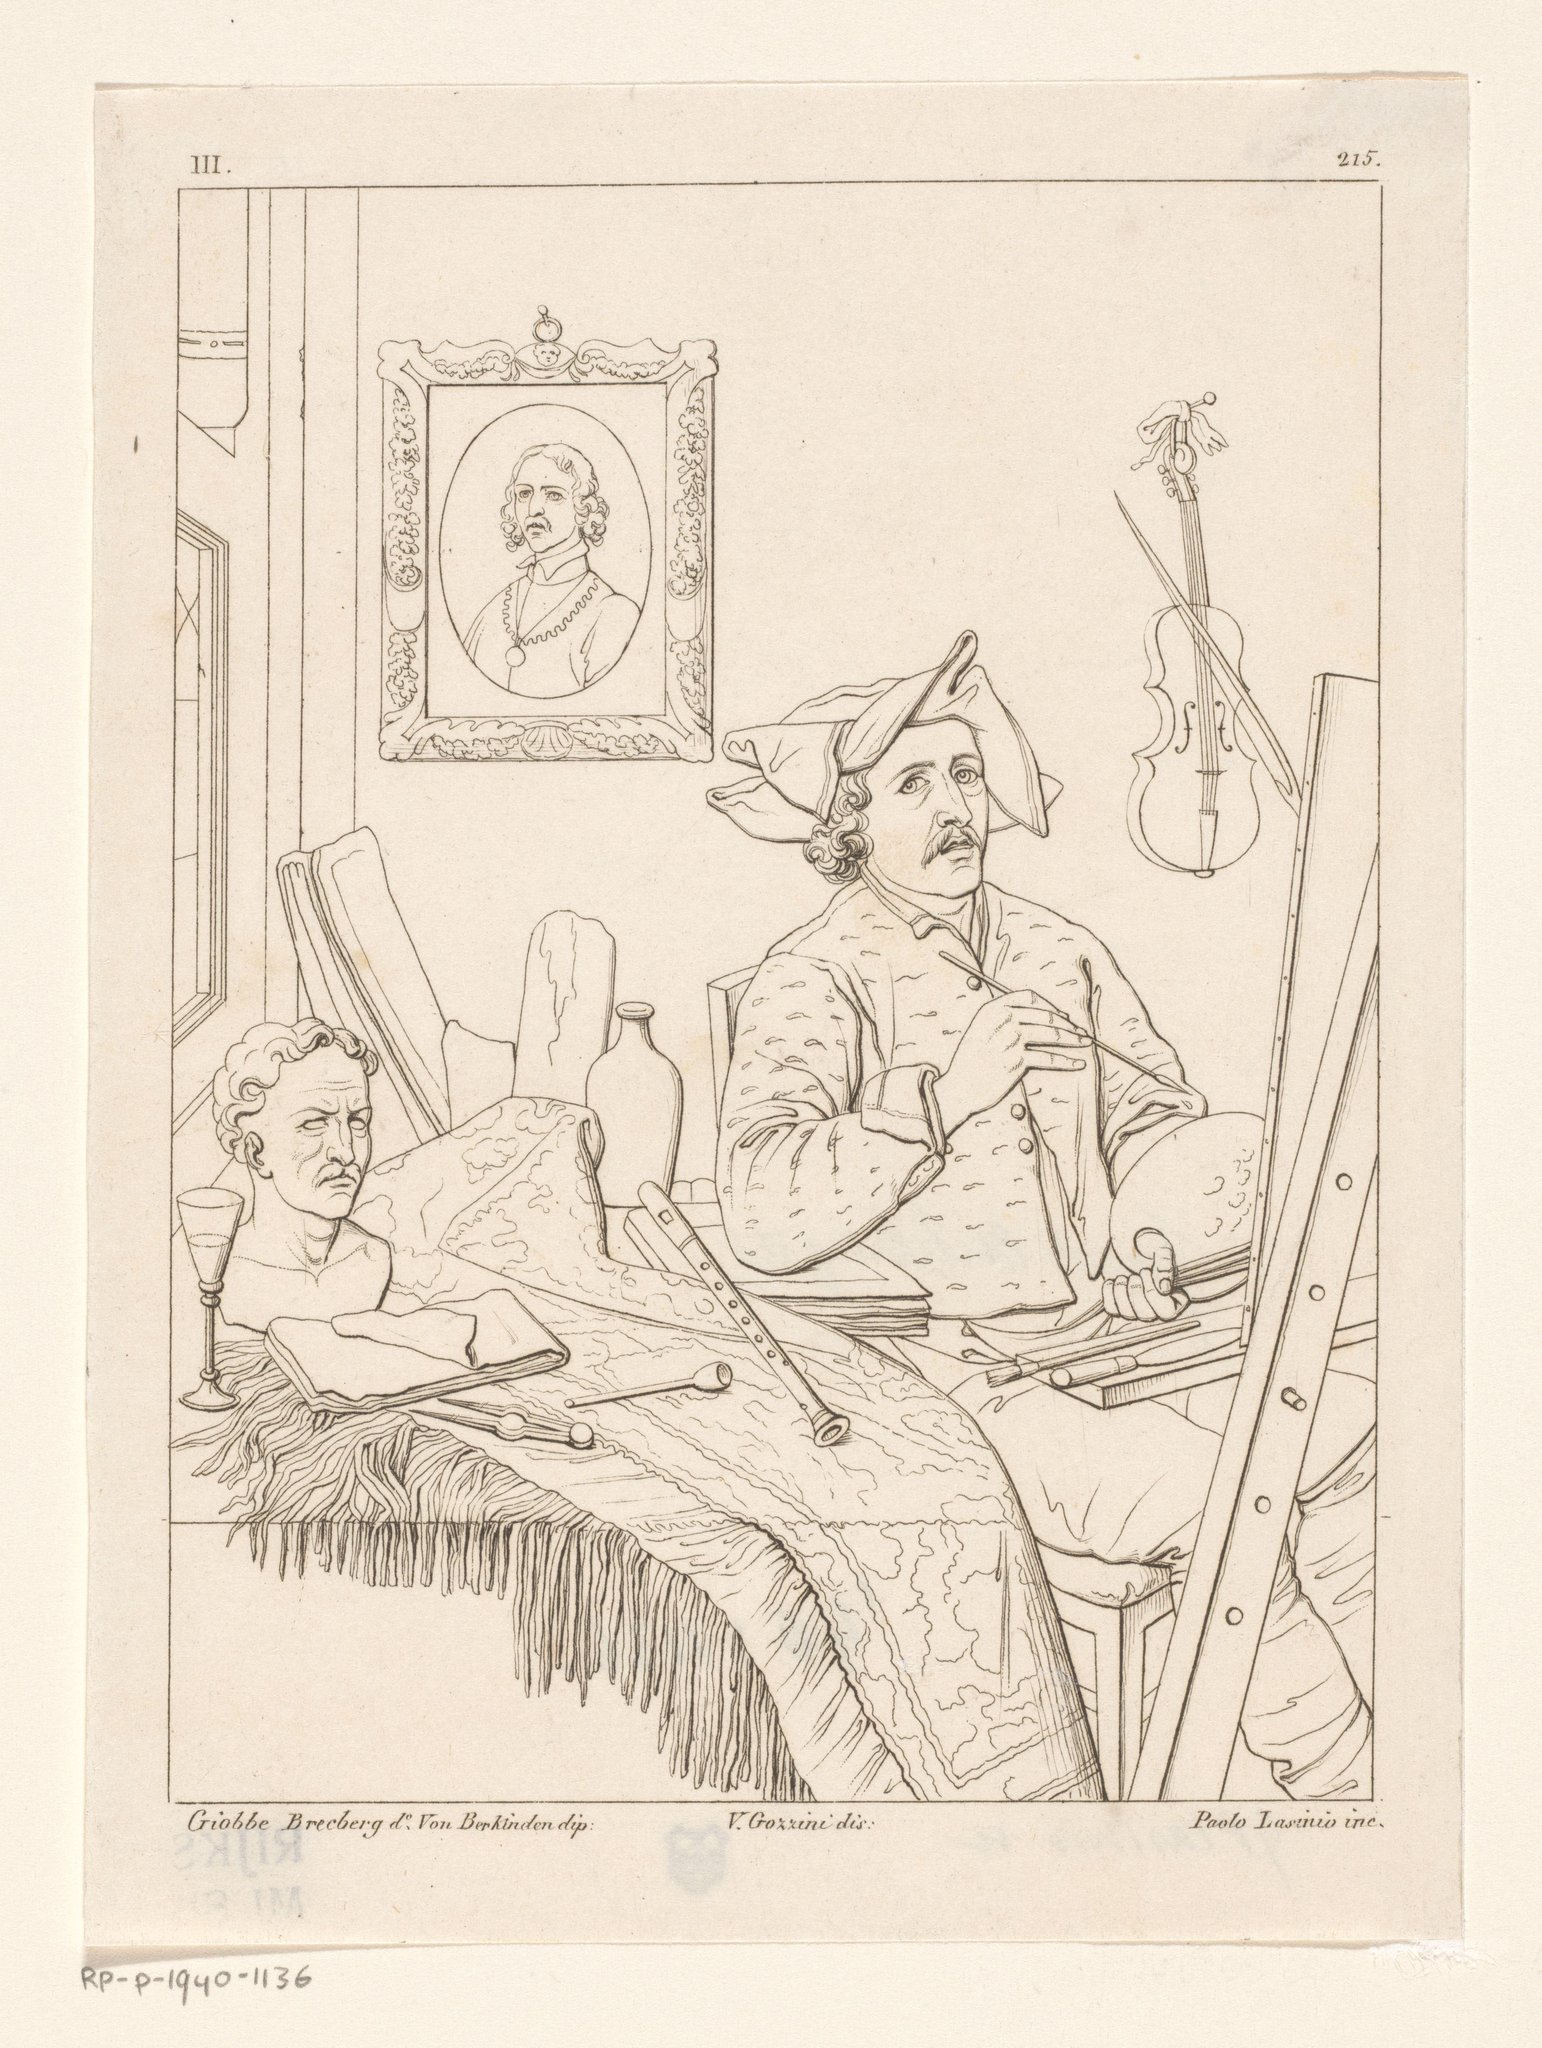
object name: print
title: Portret van kunstenaar Job Adriaensz Berckheyde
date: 1799-1855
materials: paper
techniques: etching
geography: italy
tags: haarlem, painter, draughtsman, job adriaensz berckheyde, violin, fiddle, portrait, self-portrait of painter, recorder (musical instrument)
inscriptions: collector's mark: Lugt 2760, collector's mark: Lugt 2166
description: Kunstenaar Job Berckheyde, zittend achter zijn schildersezel, met palet en penseel in de hand. Linksvoor een tafel waarop een blokfluit, passer, boek, gipsen buste en glas liggen. Aan de muur hangen een viool en een portret. Genummerd linksboven: III. Genummerd rechtsboven: 215.